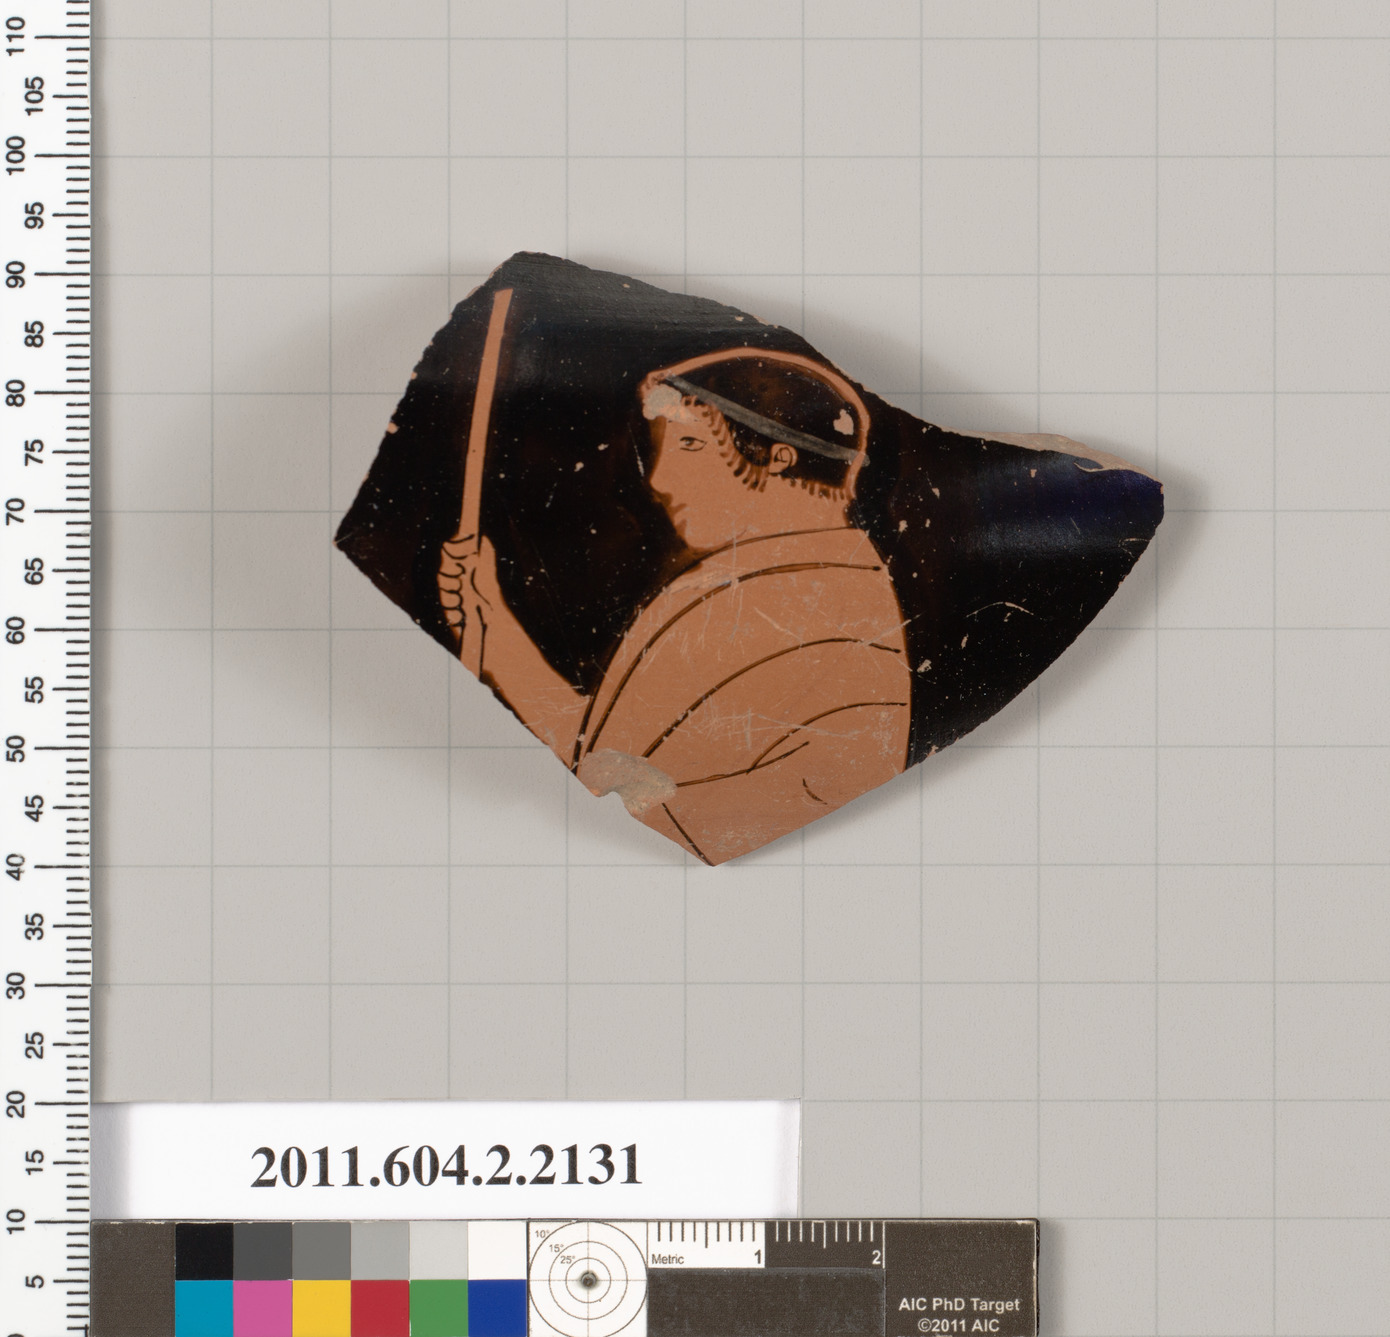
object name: neck amphora fragment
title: Terracotta fragment of a Nolan neck-amphora (jar)?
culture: greek, attic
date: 475-451 BCE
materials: terracotta